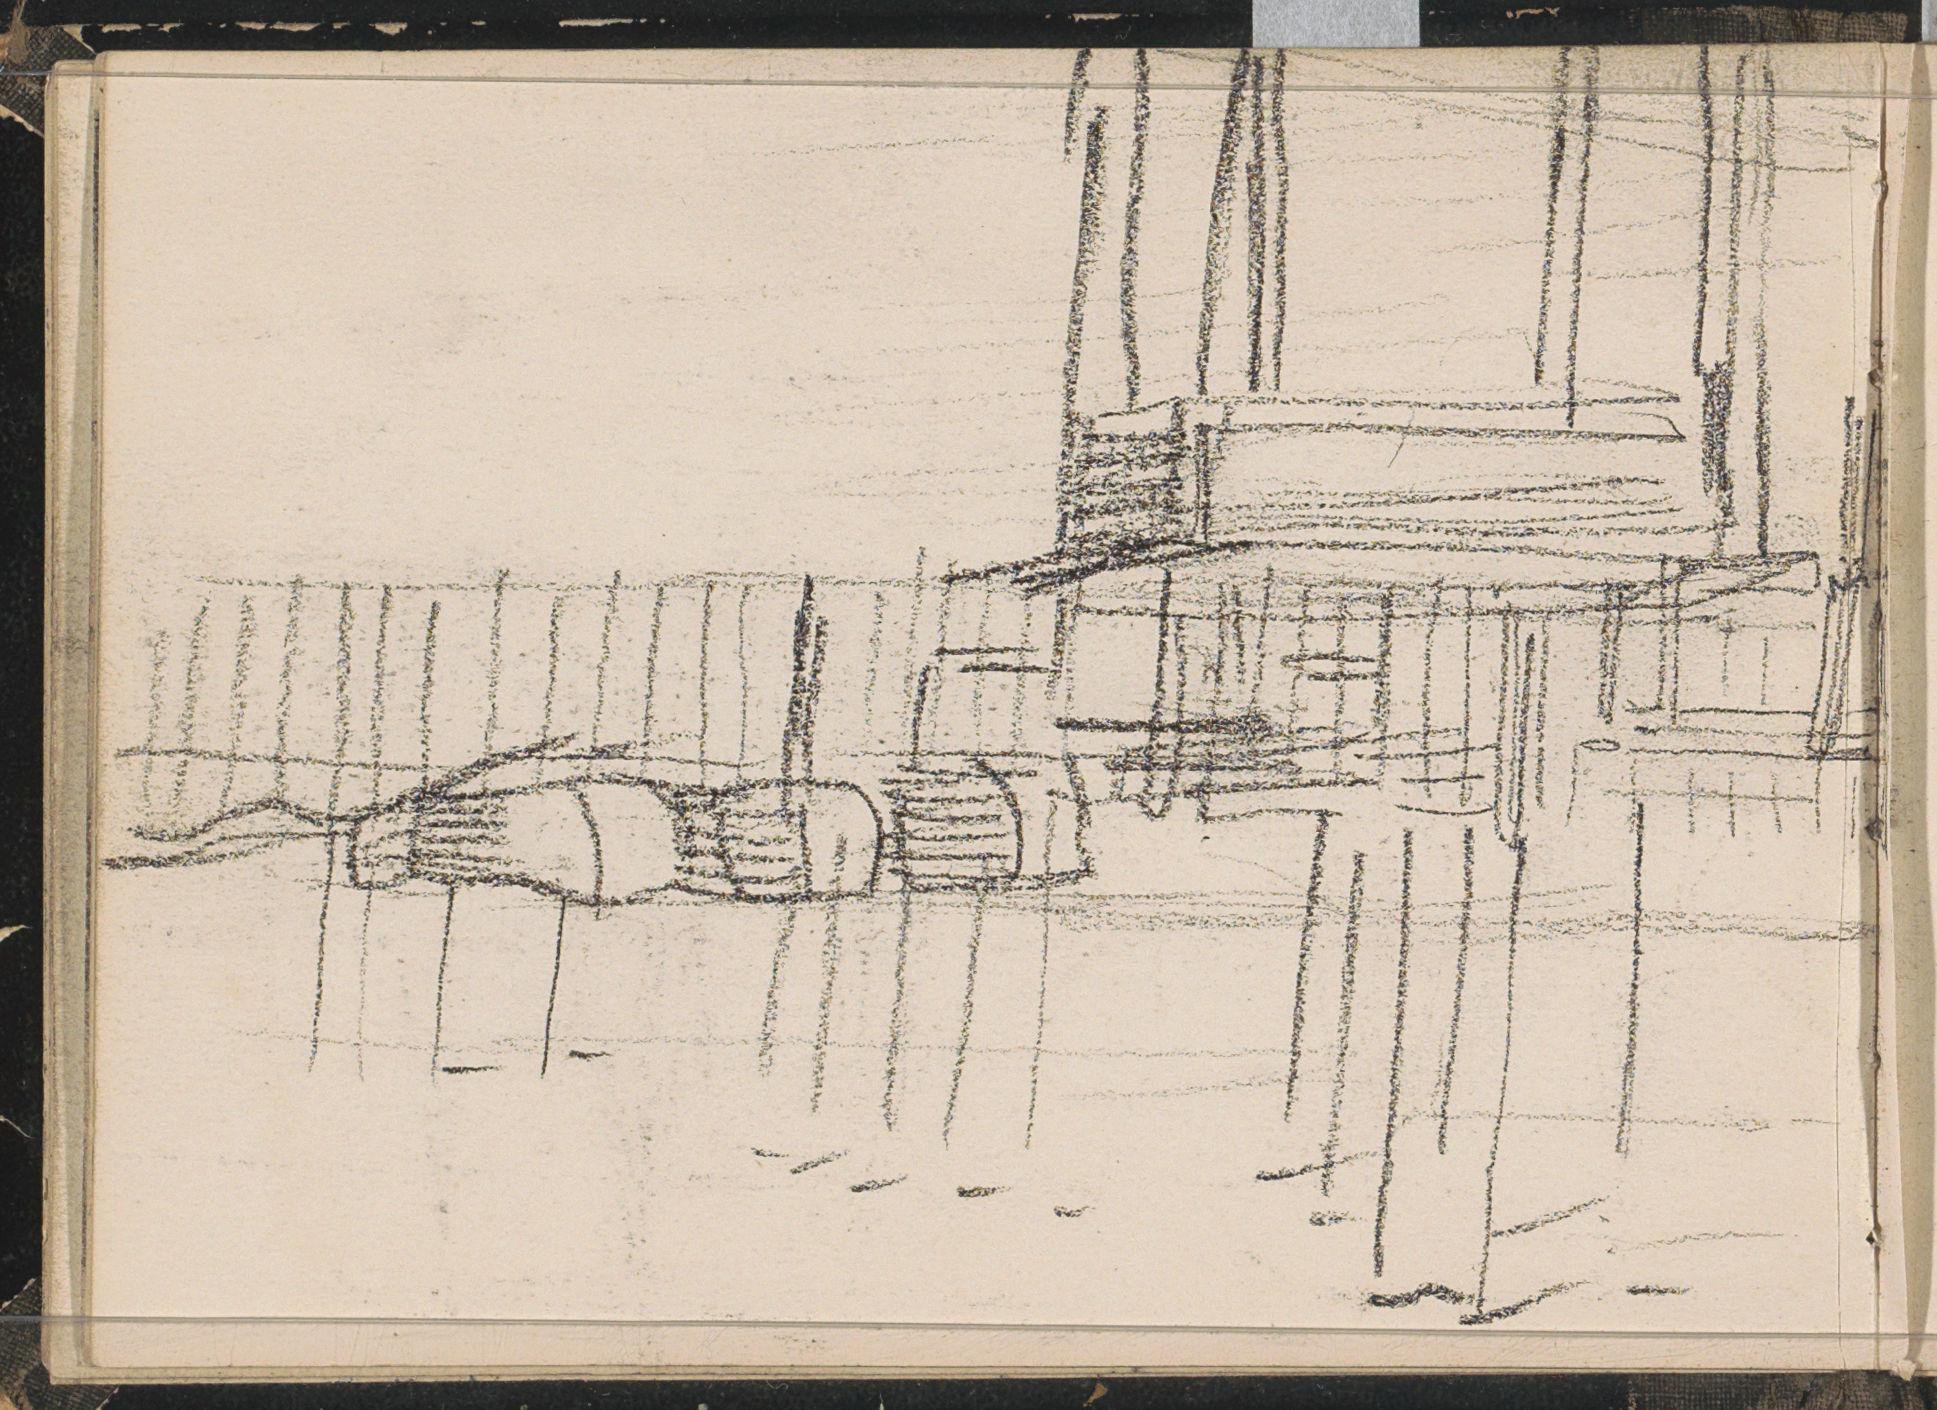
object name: sketchbook leaf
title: Tafels en stoelen op een door een balustrade omheind terras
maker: anton mauve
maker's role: draughtsman, painter, print maker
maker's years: 1838-1888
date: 1848-1888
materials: chalk, paper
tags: flagpole, avenue, boulevard, promenade, esplanade (+ variant)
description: Op de achtergrond een rij vlaggenmasten. Mogelijk een terras aan een boulevard. Blad 9 verso uit een schetsboek met 33 bladen.